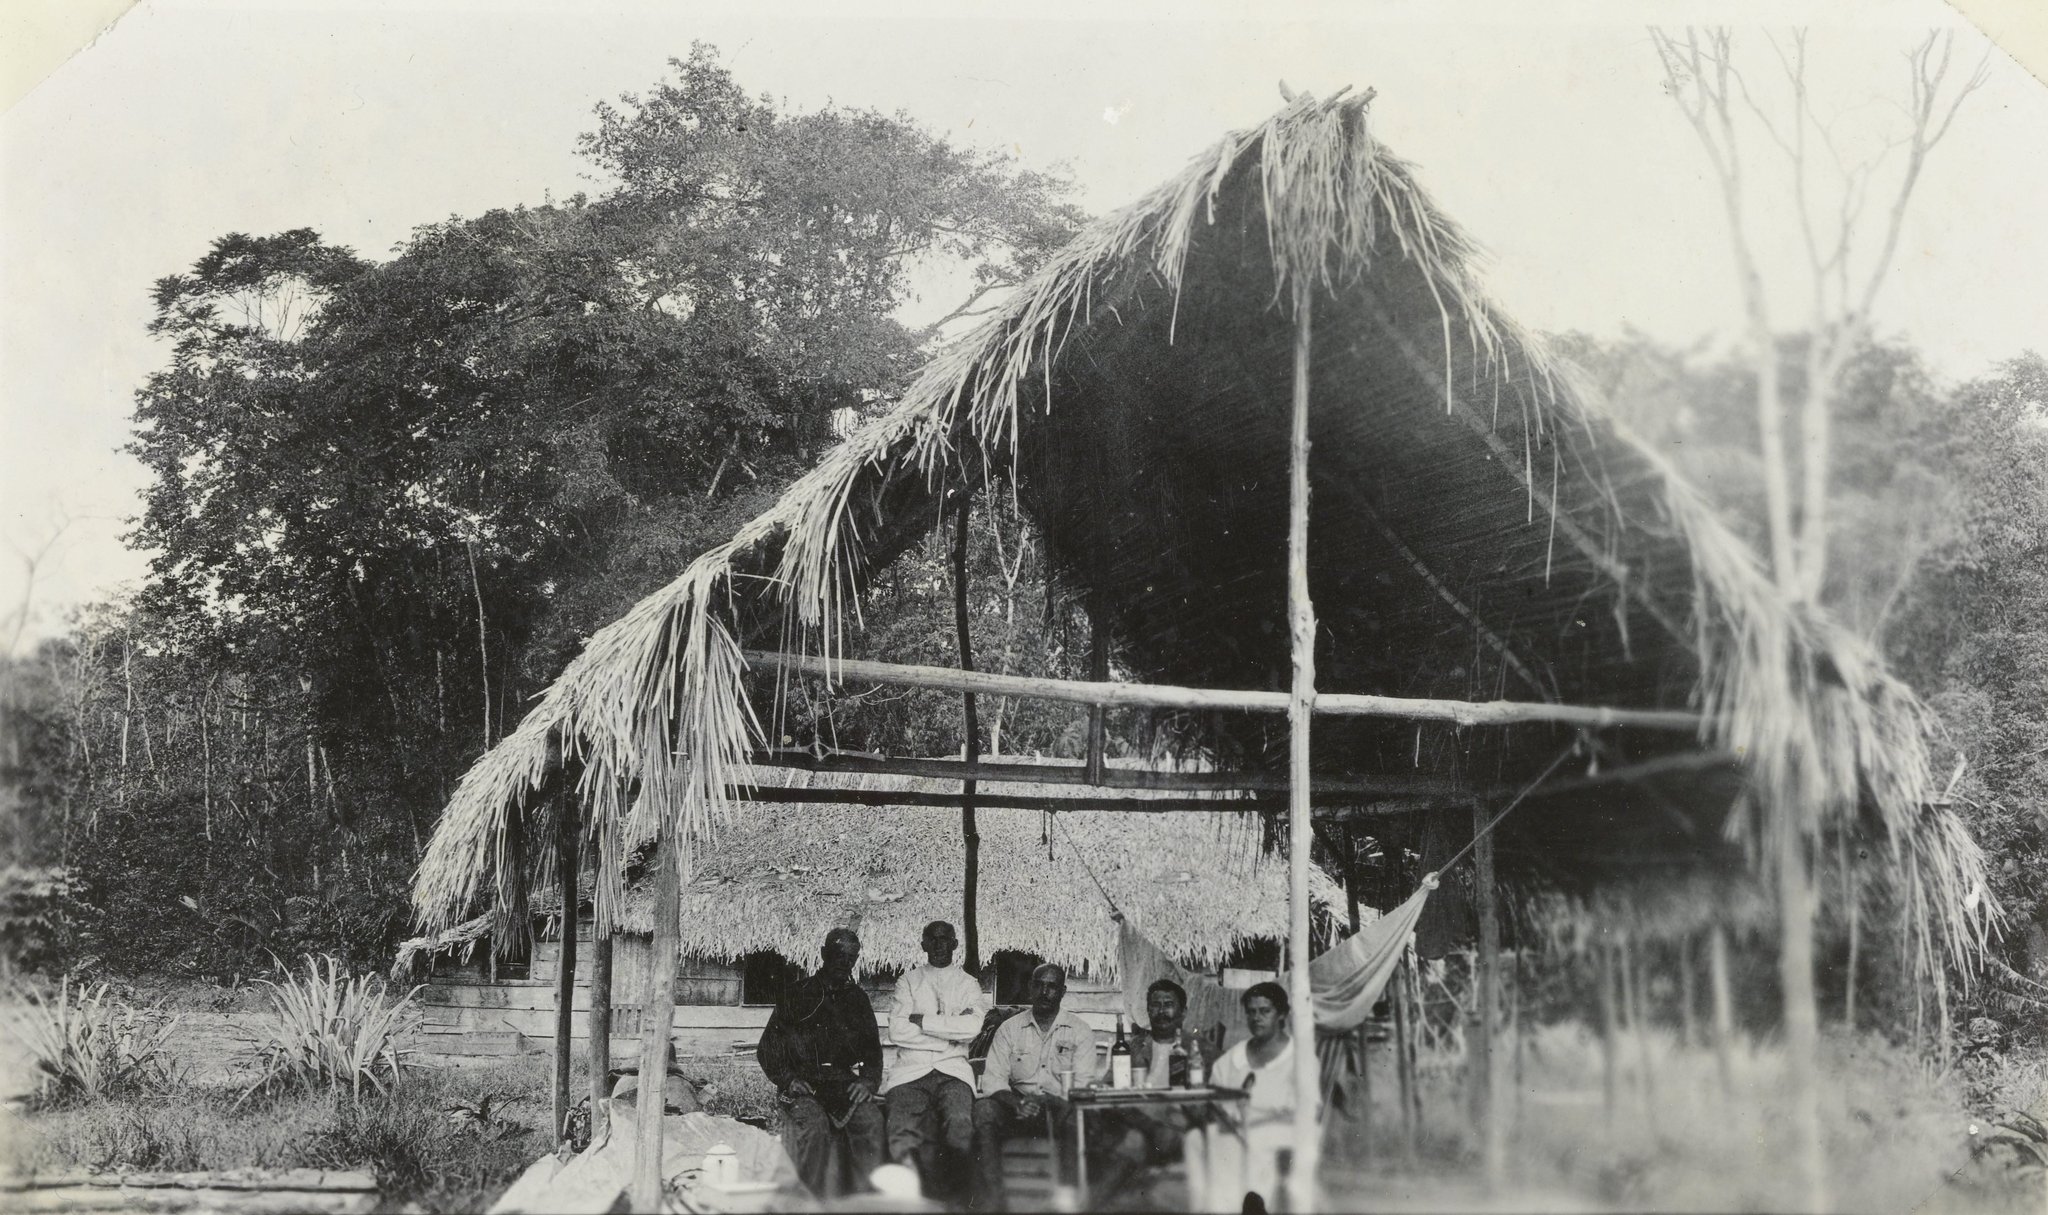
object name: photograph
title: Het echtpaar Brouwers met vrienden in een hut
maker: Anonymous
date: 1911-1932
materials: photographic support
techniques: photography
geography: suriname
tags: theodoor brouwers, suriname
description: In de periode 1911-1932 woonde op plantage Accaribo in Suriname de familie Brouwers van wie de foto's afkomstig zijn. Rond 1910 vond Theodoor Brouwers werk op plantage Accaribo. In 1929 werd hij eigenaar van de plantage.